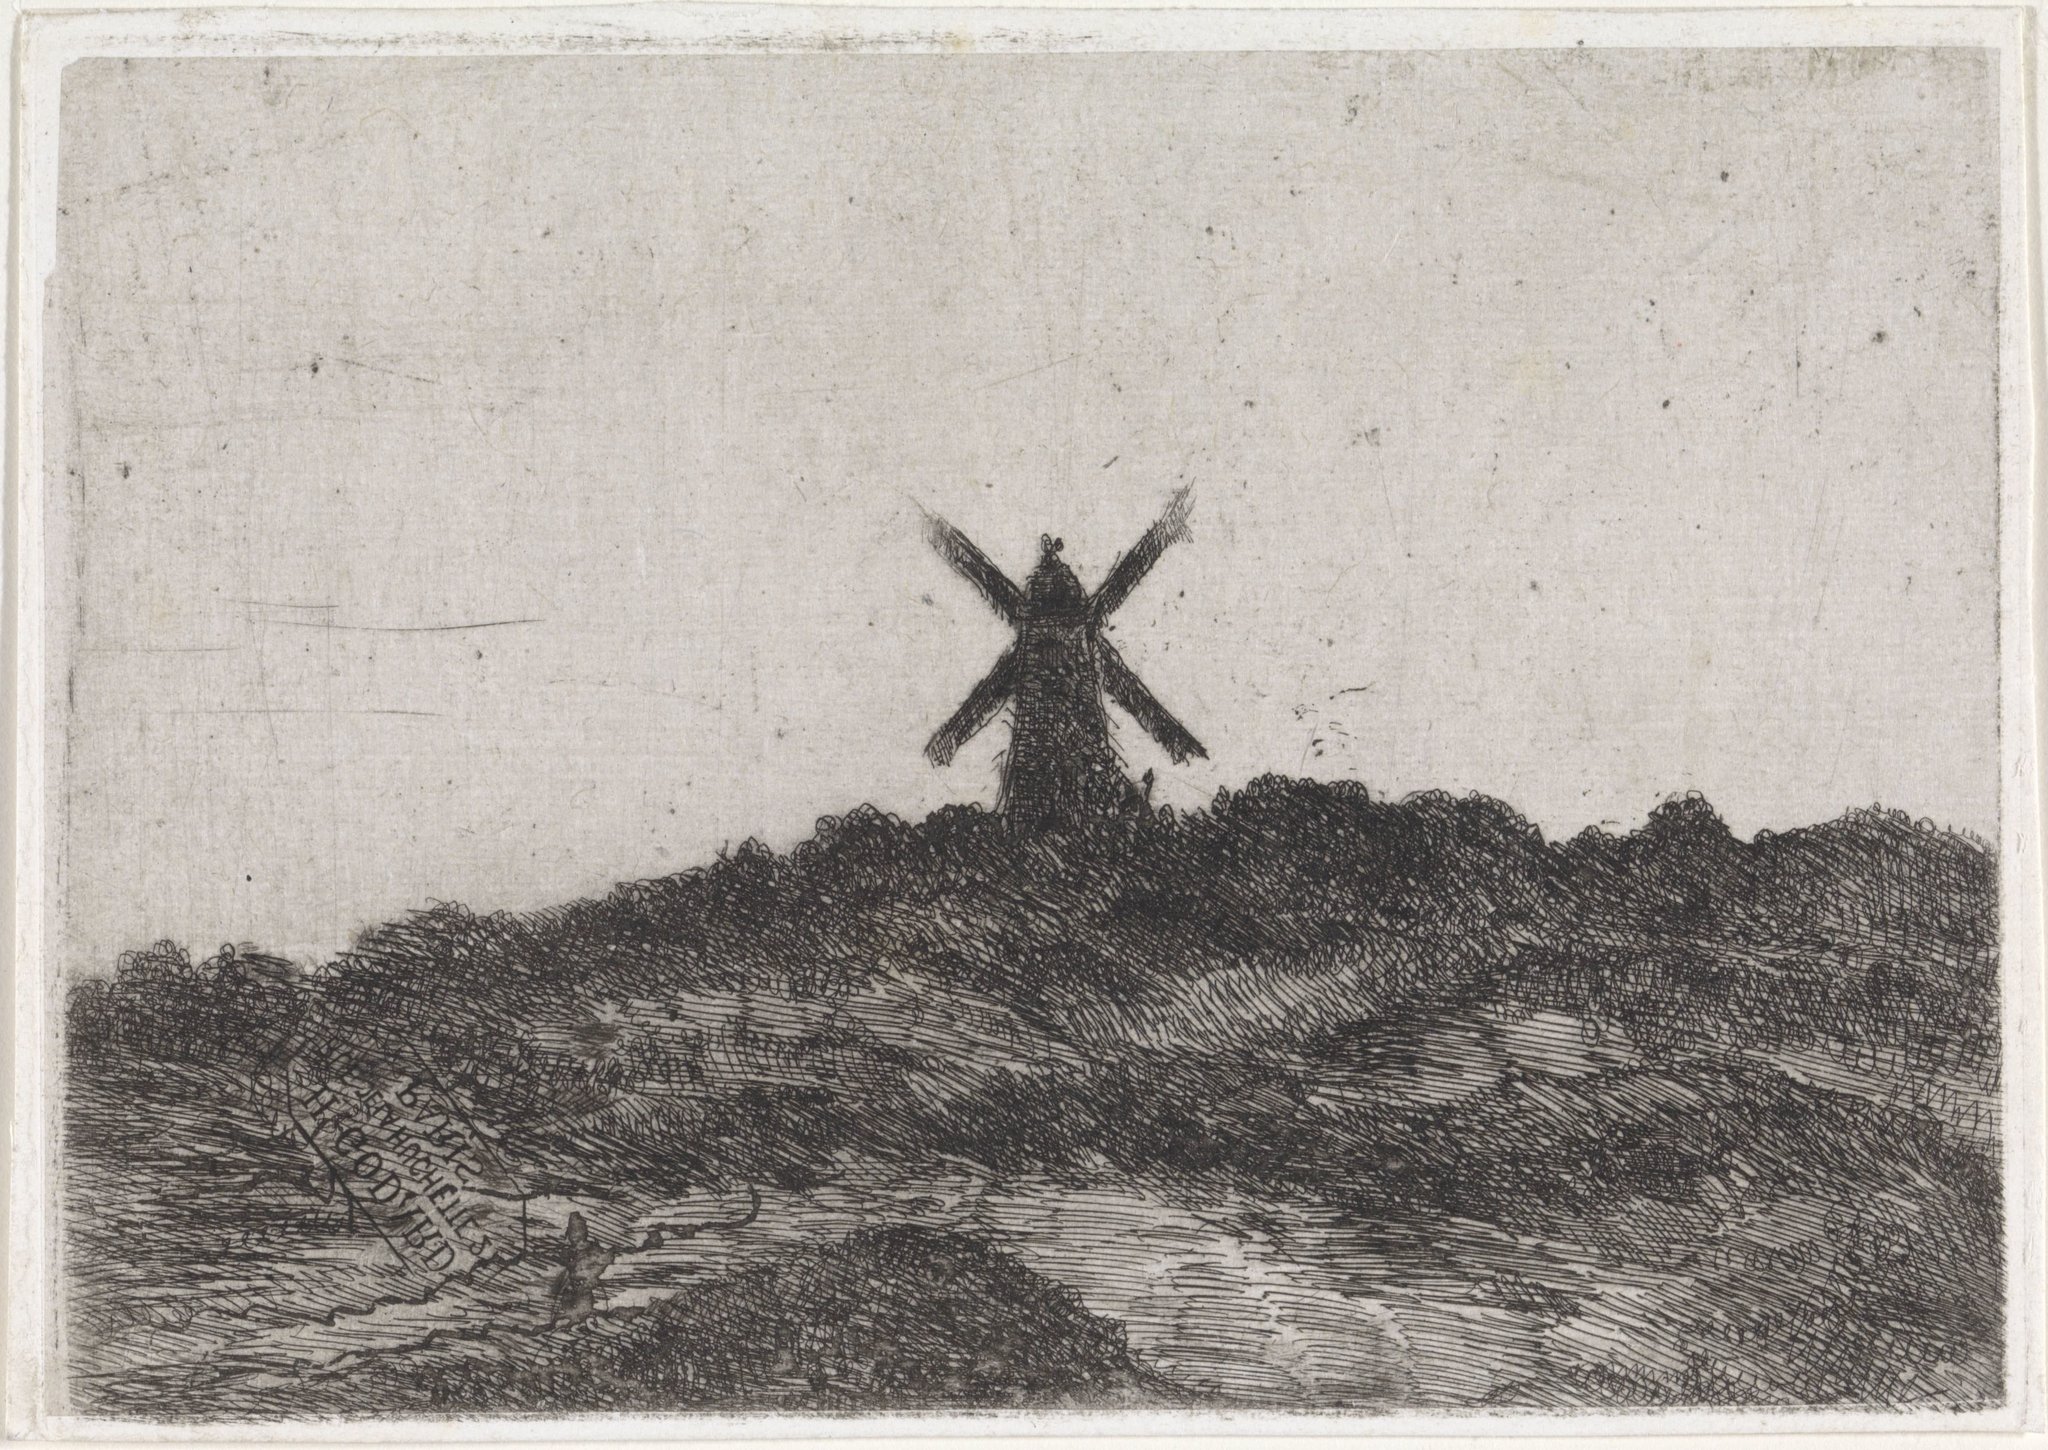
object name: print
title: Molen in een duinlandschap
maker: arnoud schaepkens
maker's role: print maker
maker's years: 1816-1904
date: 1855-1904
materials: paper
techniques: drypoint, etching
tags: dunes (sea not visible); in the dunes, watermill in landscape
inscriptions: stamp: ‘H.Godard / Rue de la Huchette 27 / Paris (in spiegelbeeld)’, collector's mark: Lugt 2228